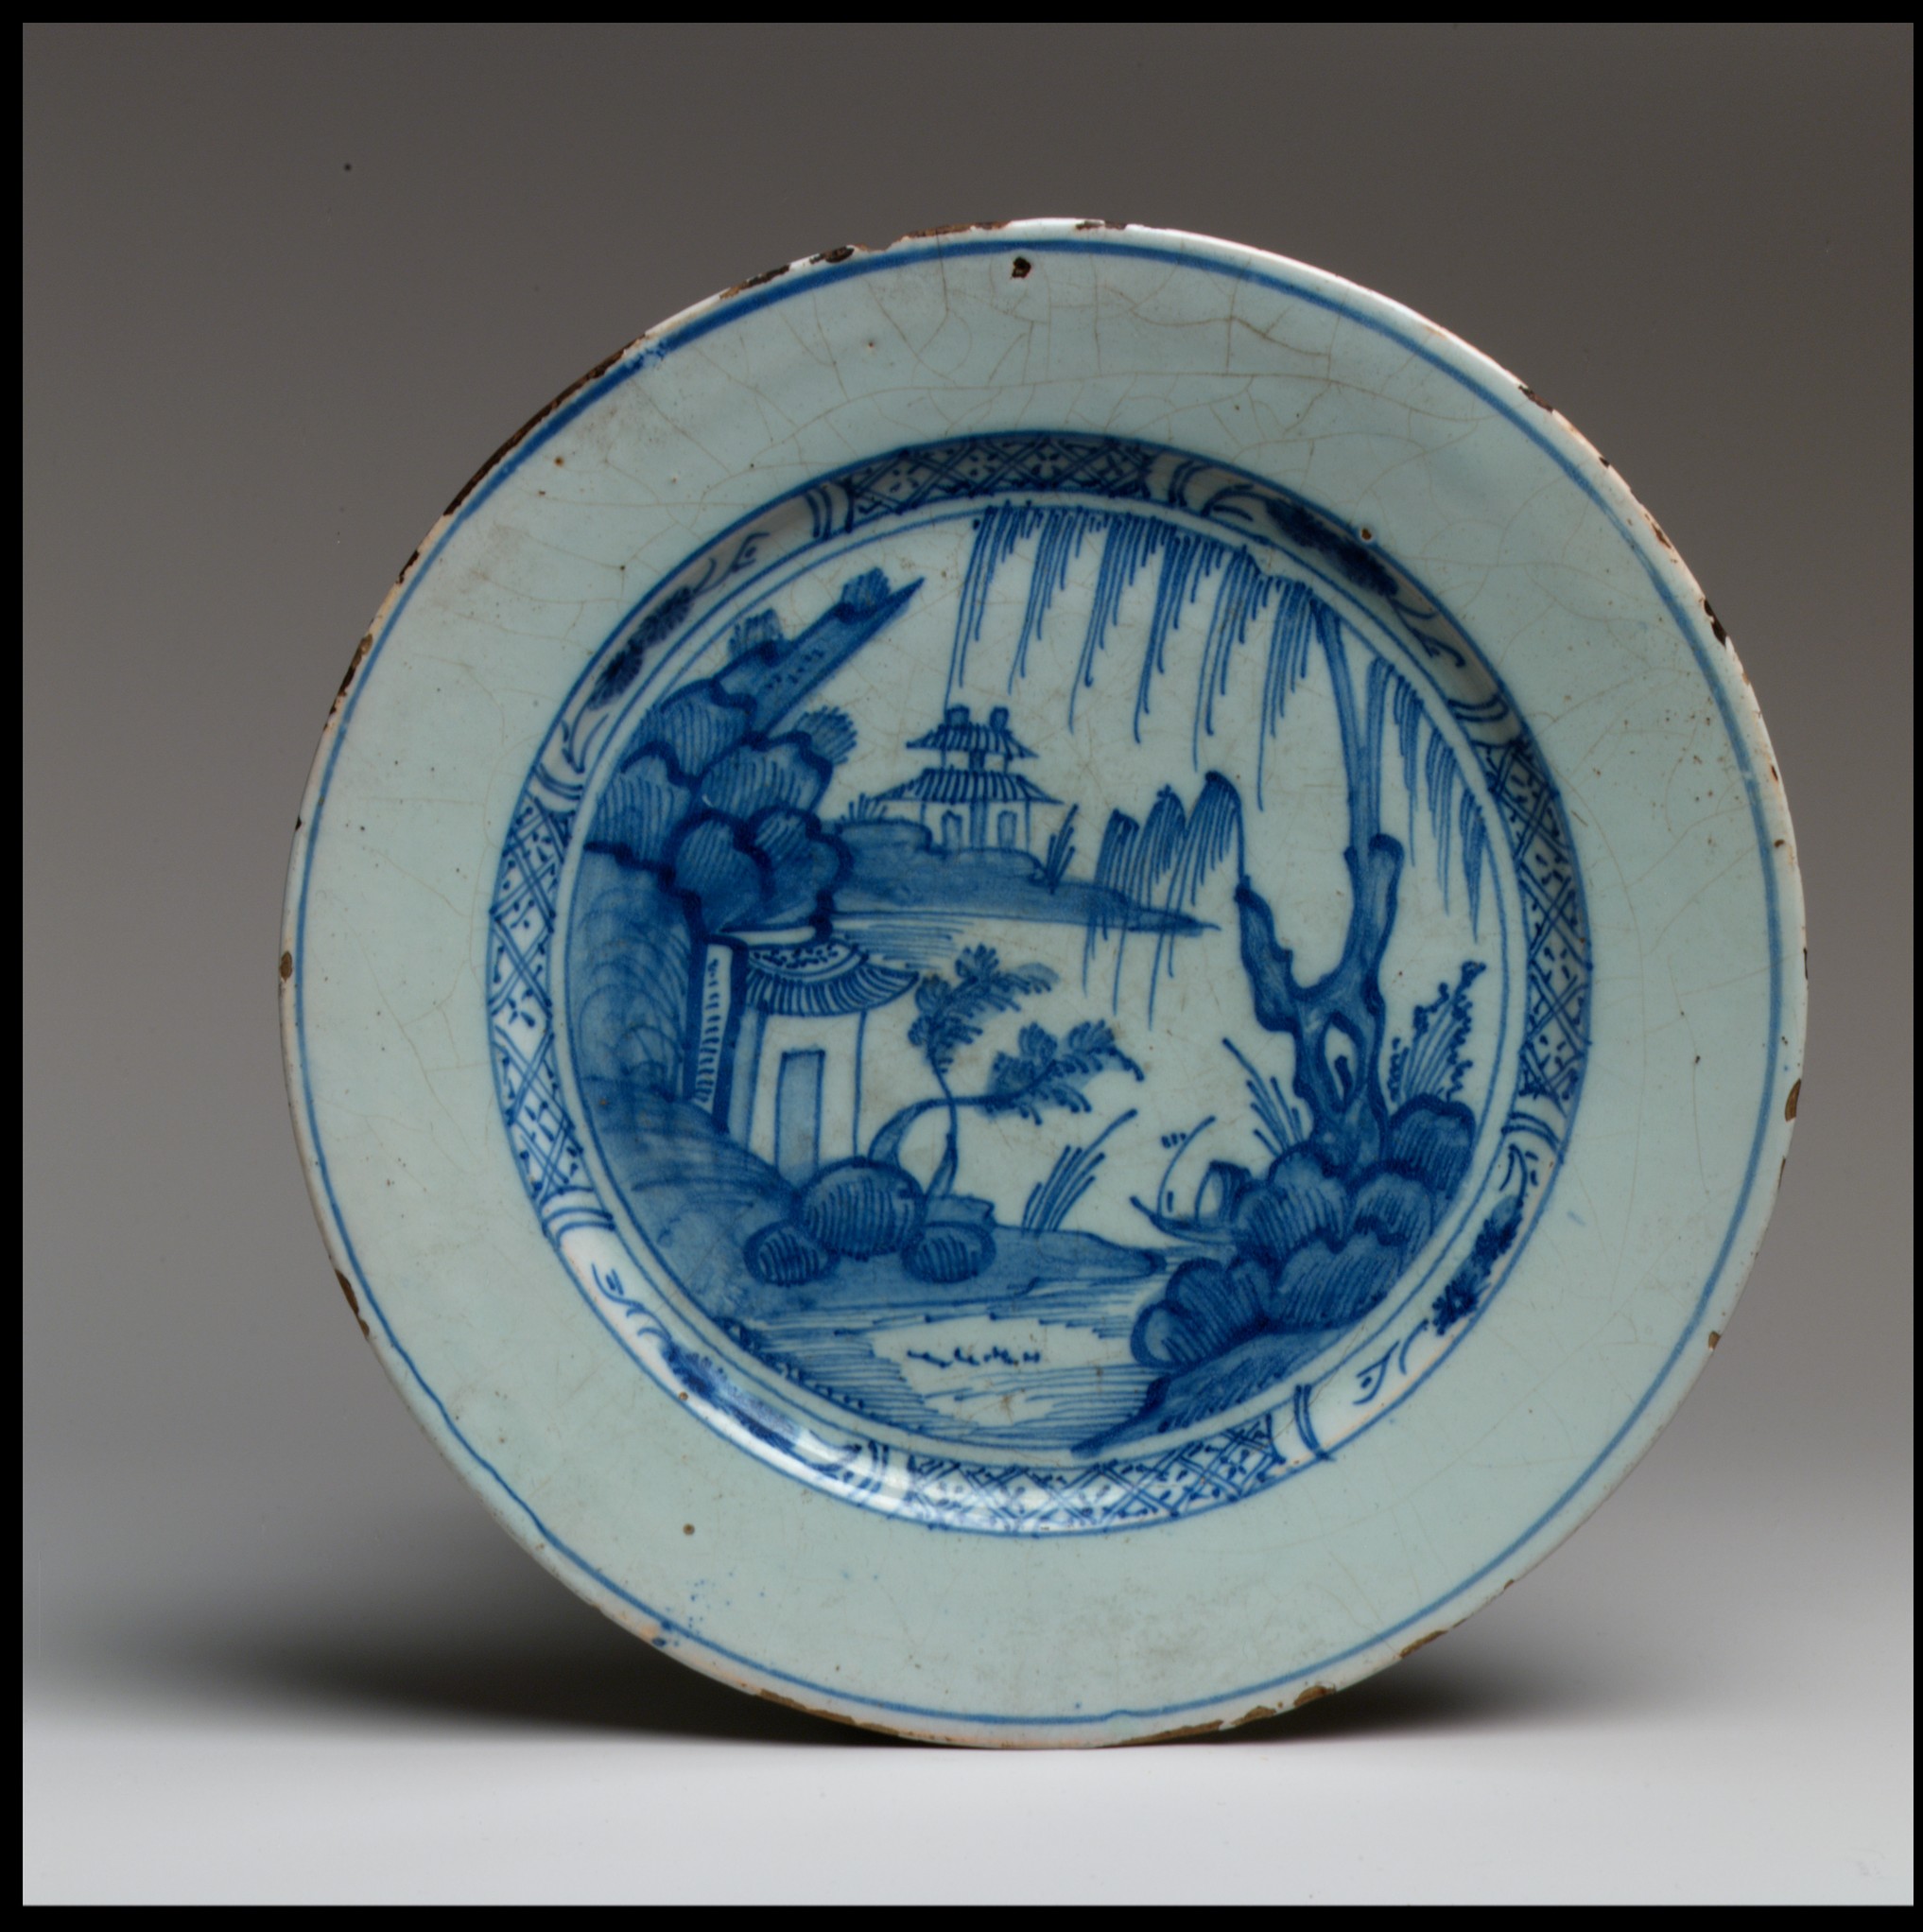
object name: plate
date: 1750-1760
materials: earthenware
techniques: glazing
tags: houses,trees